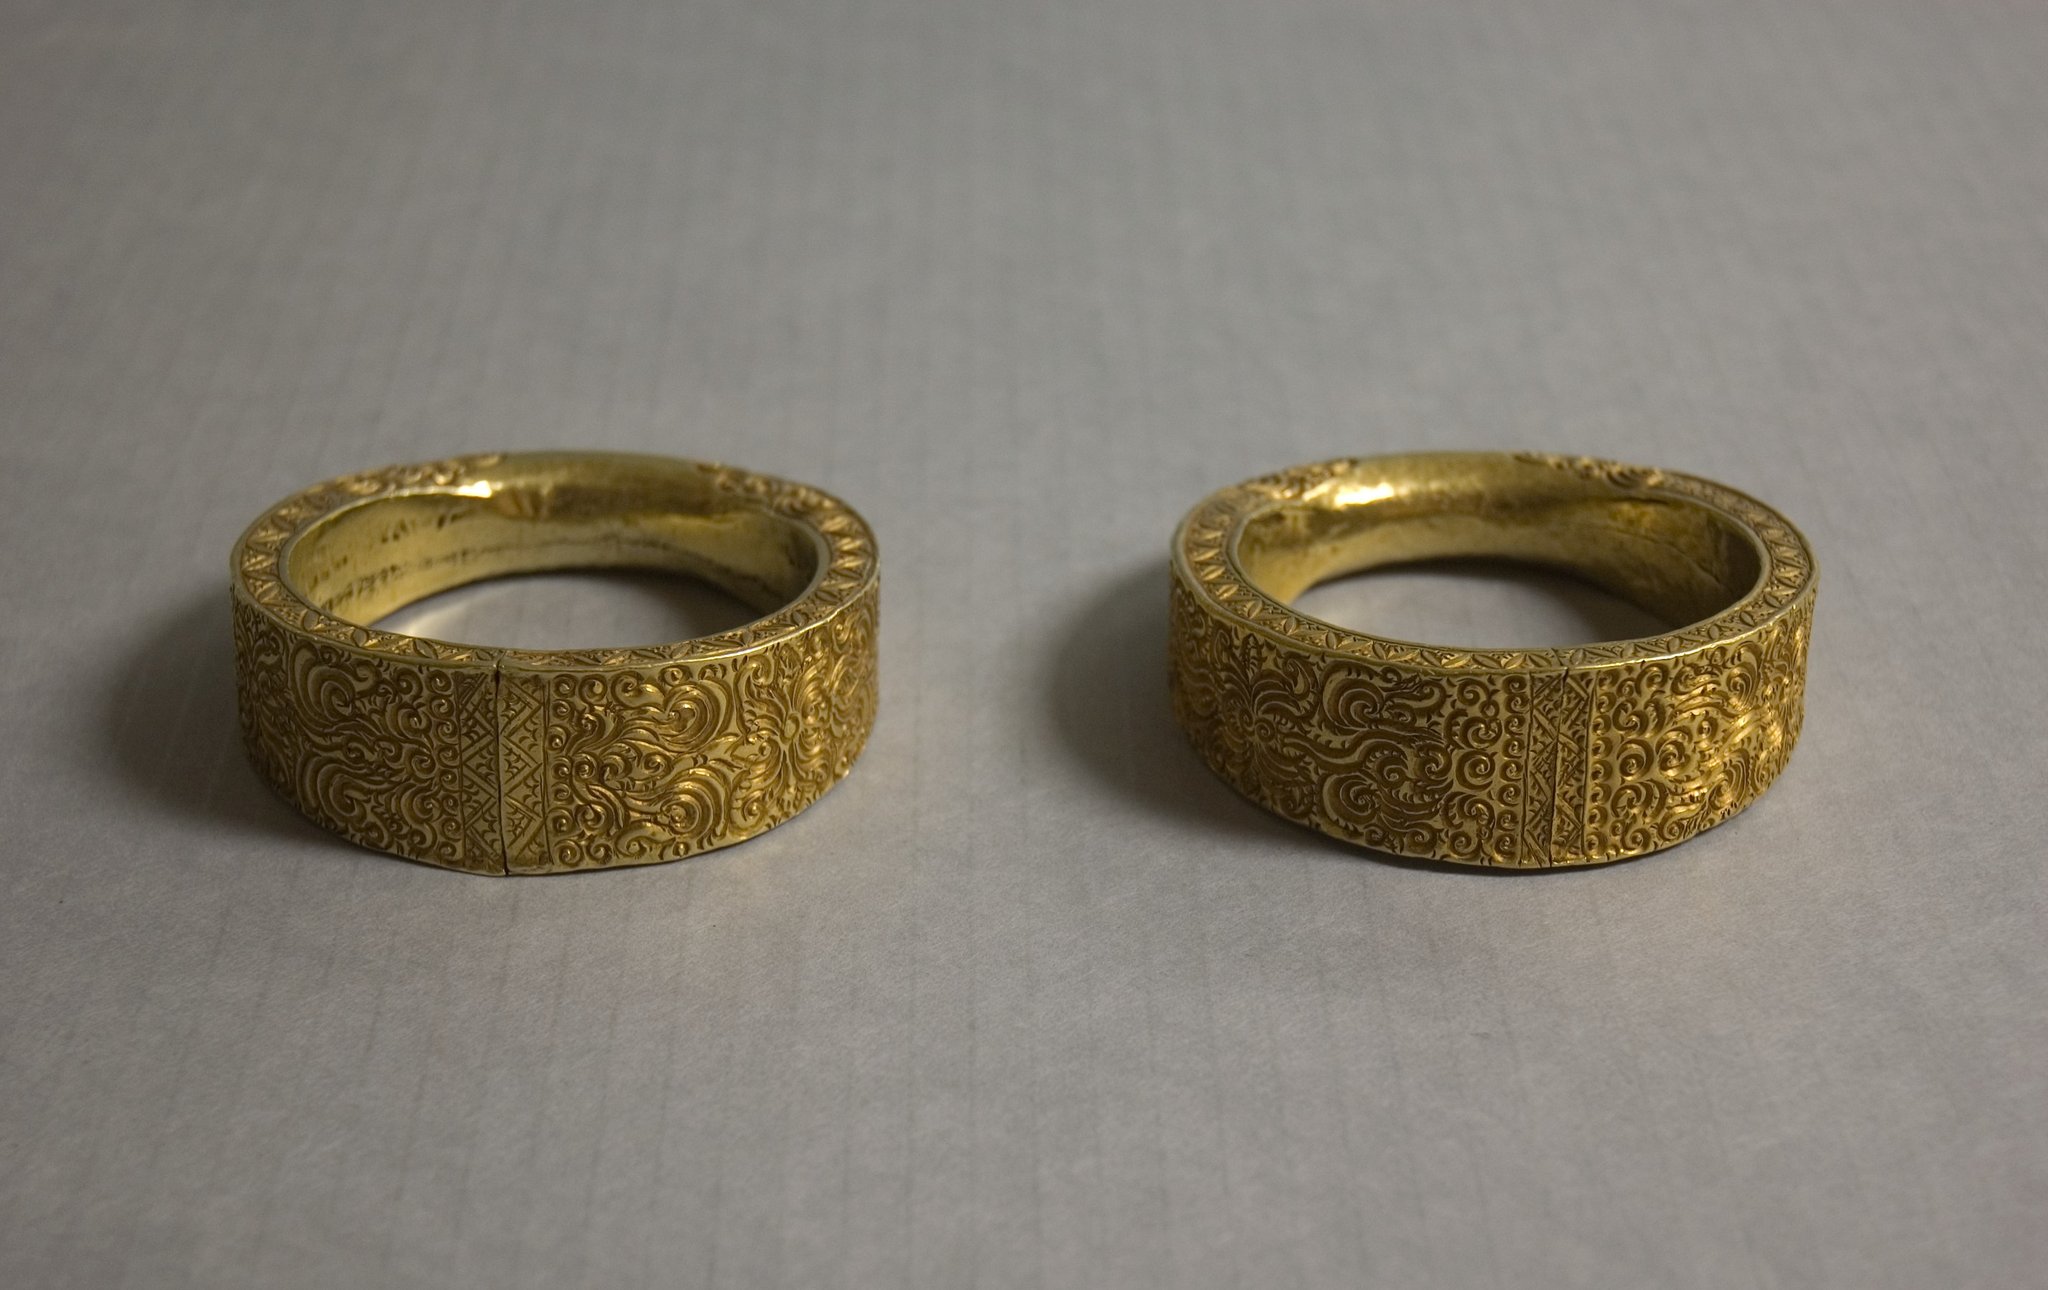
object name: bracelet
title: Pair of Bracelets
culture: indonesian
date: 1801-1900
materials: gold, metal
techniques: chasing, engraving